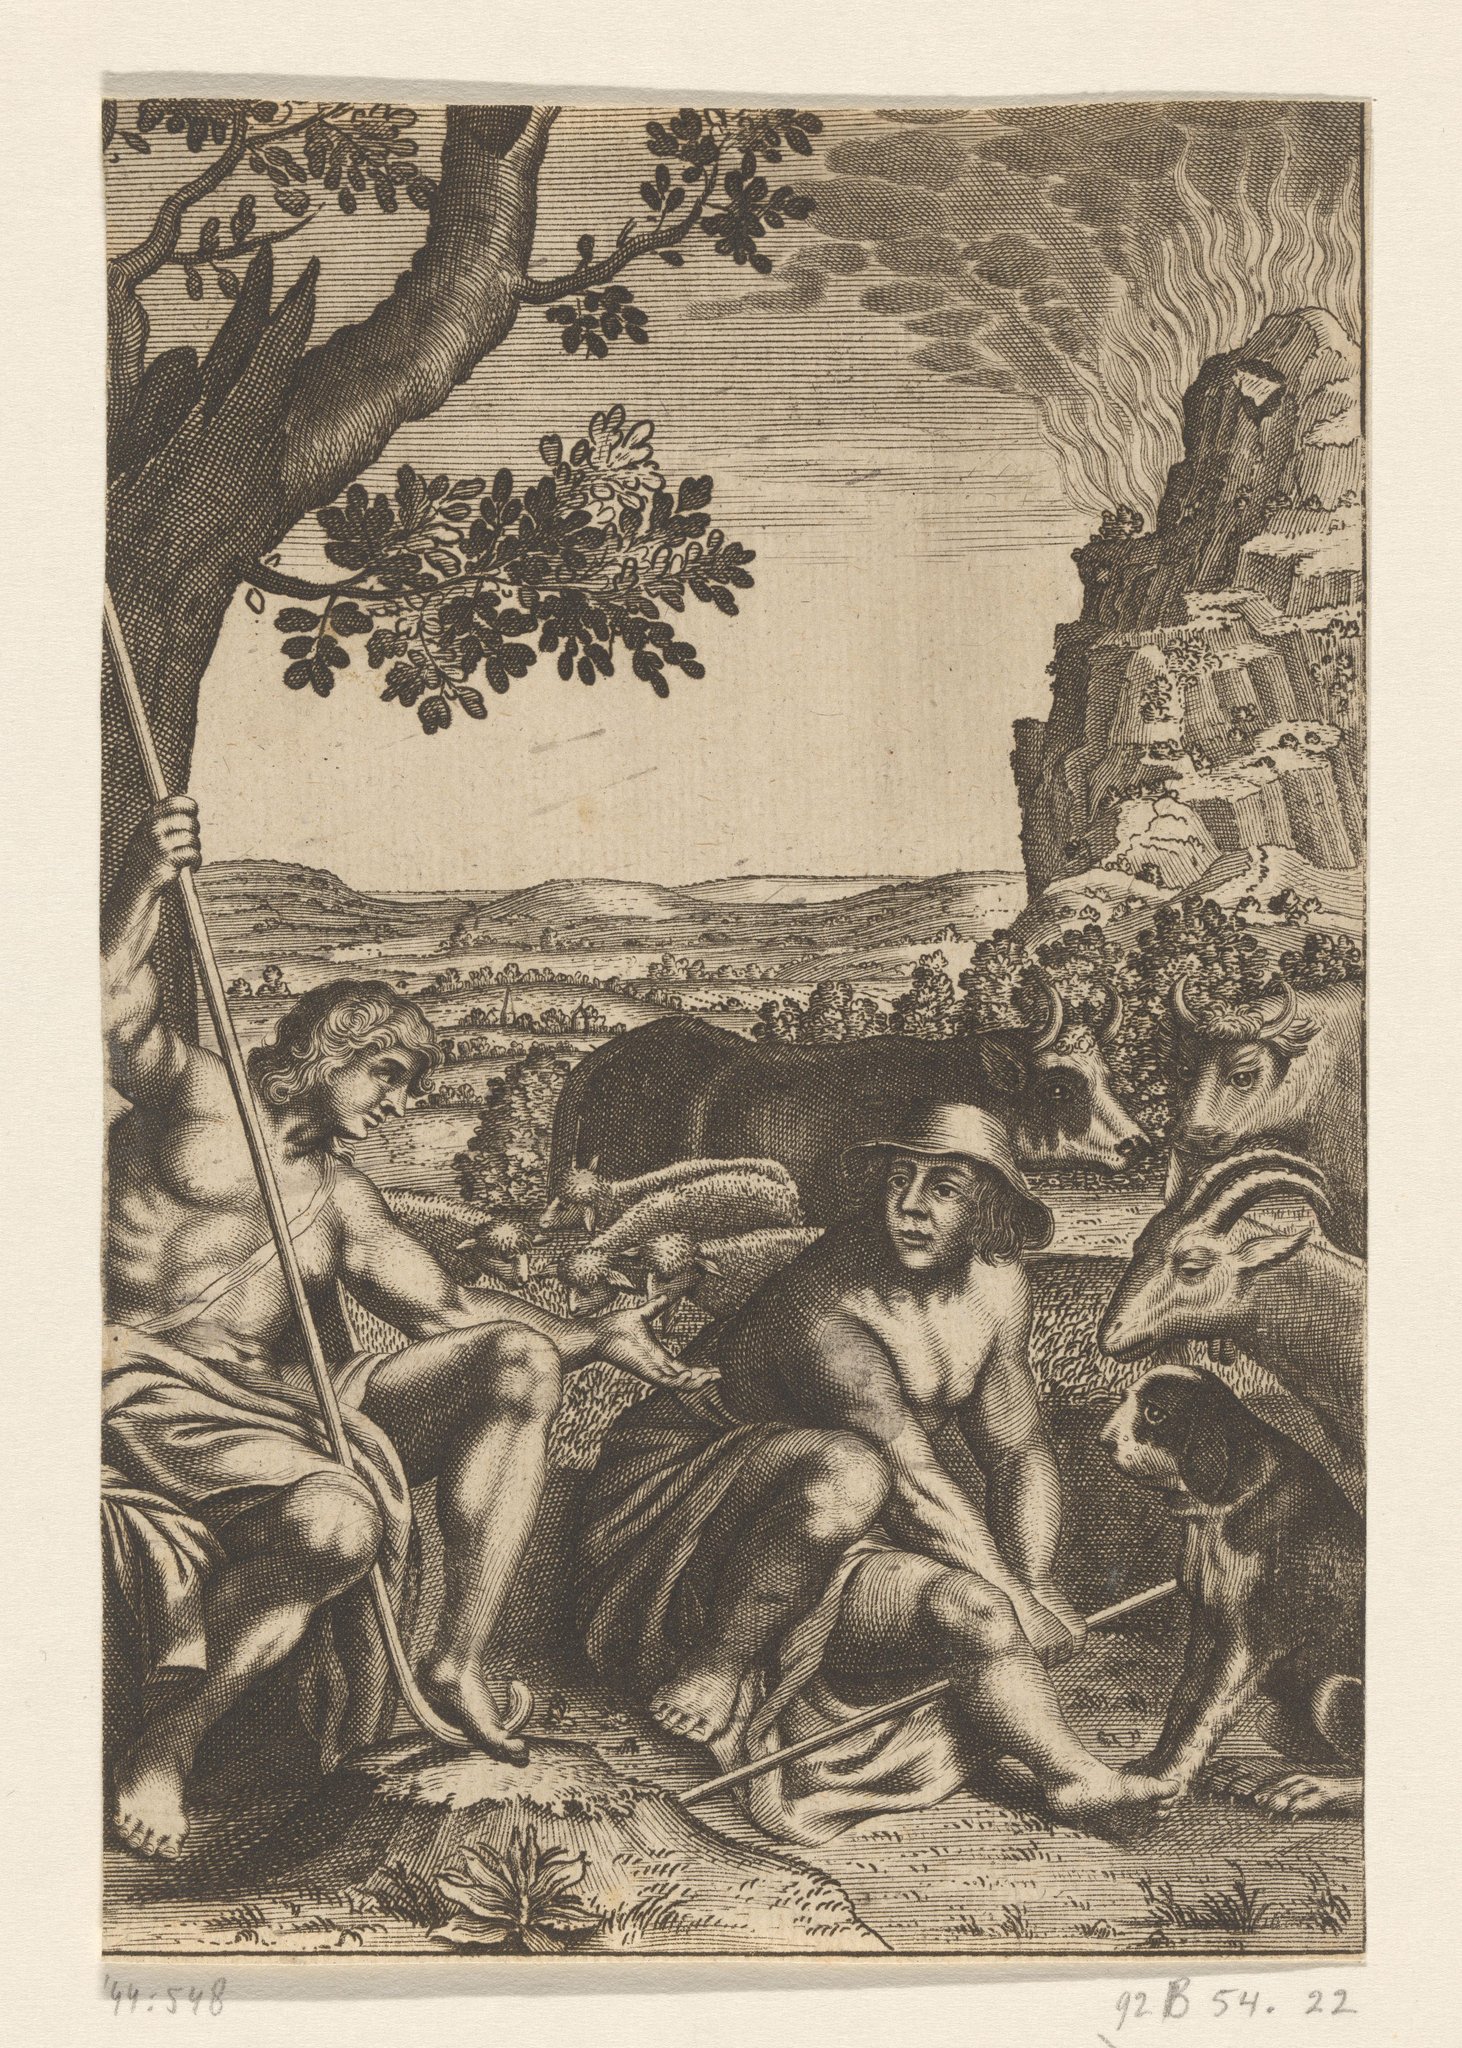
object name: print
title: Mercurius en Battus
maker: Anonymous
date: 1699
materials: paper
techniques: engraving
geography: england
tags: mercury and battus; battus is bribed with a heifer as hush-money, dog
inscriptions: collector's mark: Lugt 2228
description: Gebruikt als frontispice in: Theokritou ta evriskomena. Theocriti quæ extant cum graecis scholiis notis et indicibus. Oxoniae : E Theatro Sheldoniano, impensis Sam. Smith, & Benj. Walford, 1699.